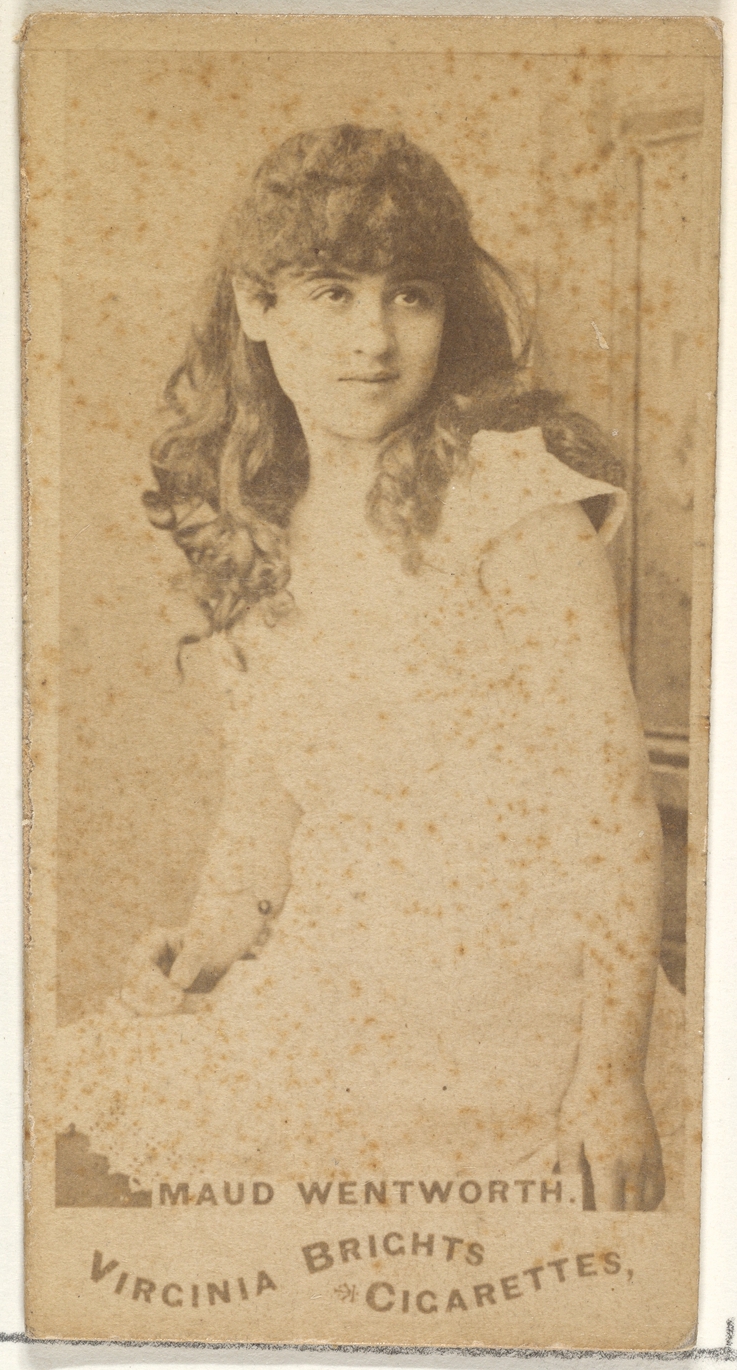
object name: photograph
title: Maud Wentworth, from the Actors and Actresses series (N45, Type 1) for Virginia Brights Cigarettes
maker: allen & ginter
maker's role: publisher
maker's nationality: american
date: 1888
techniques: albumen silver print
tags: girls,portraits,actresses